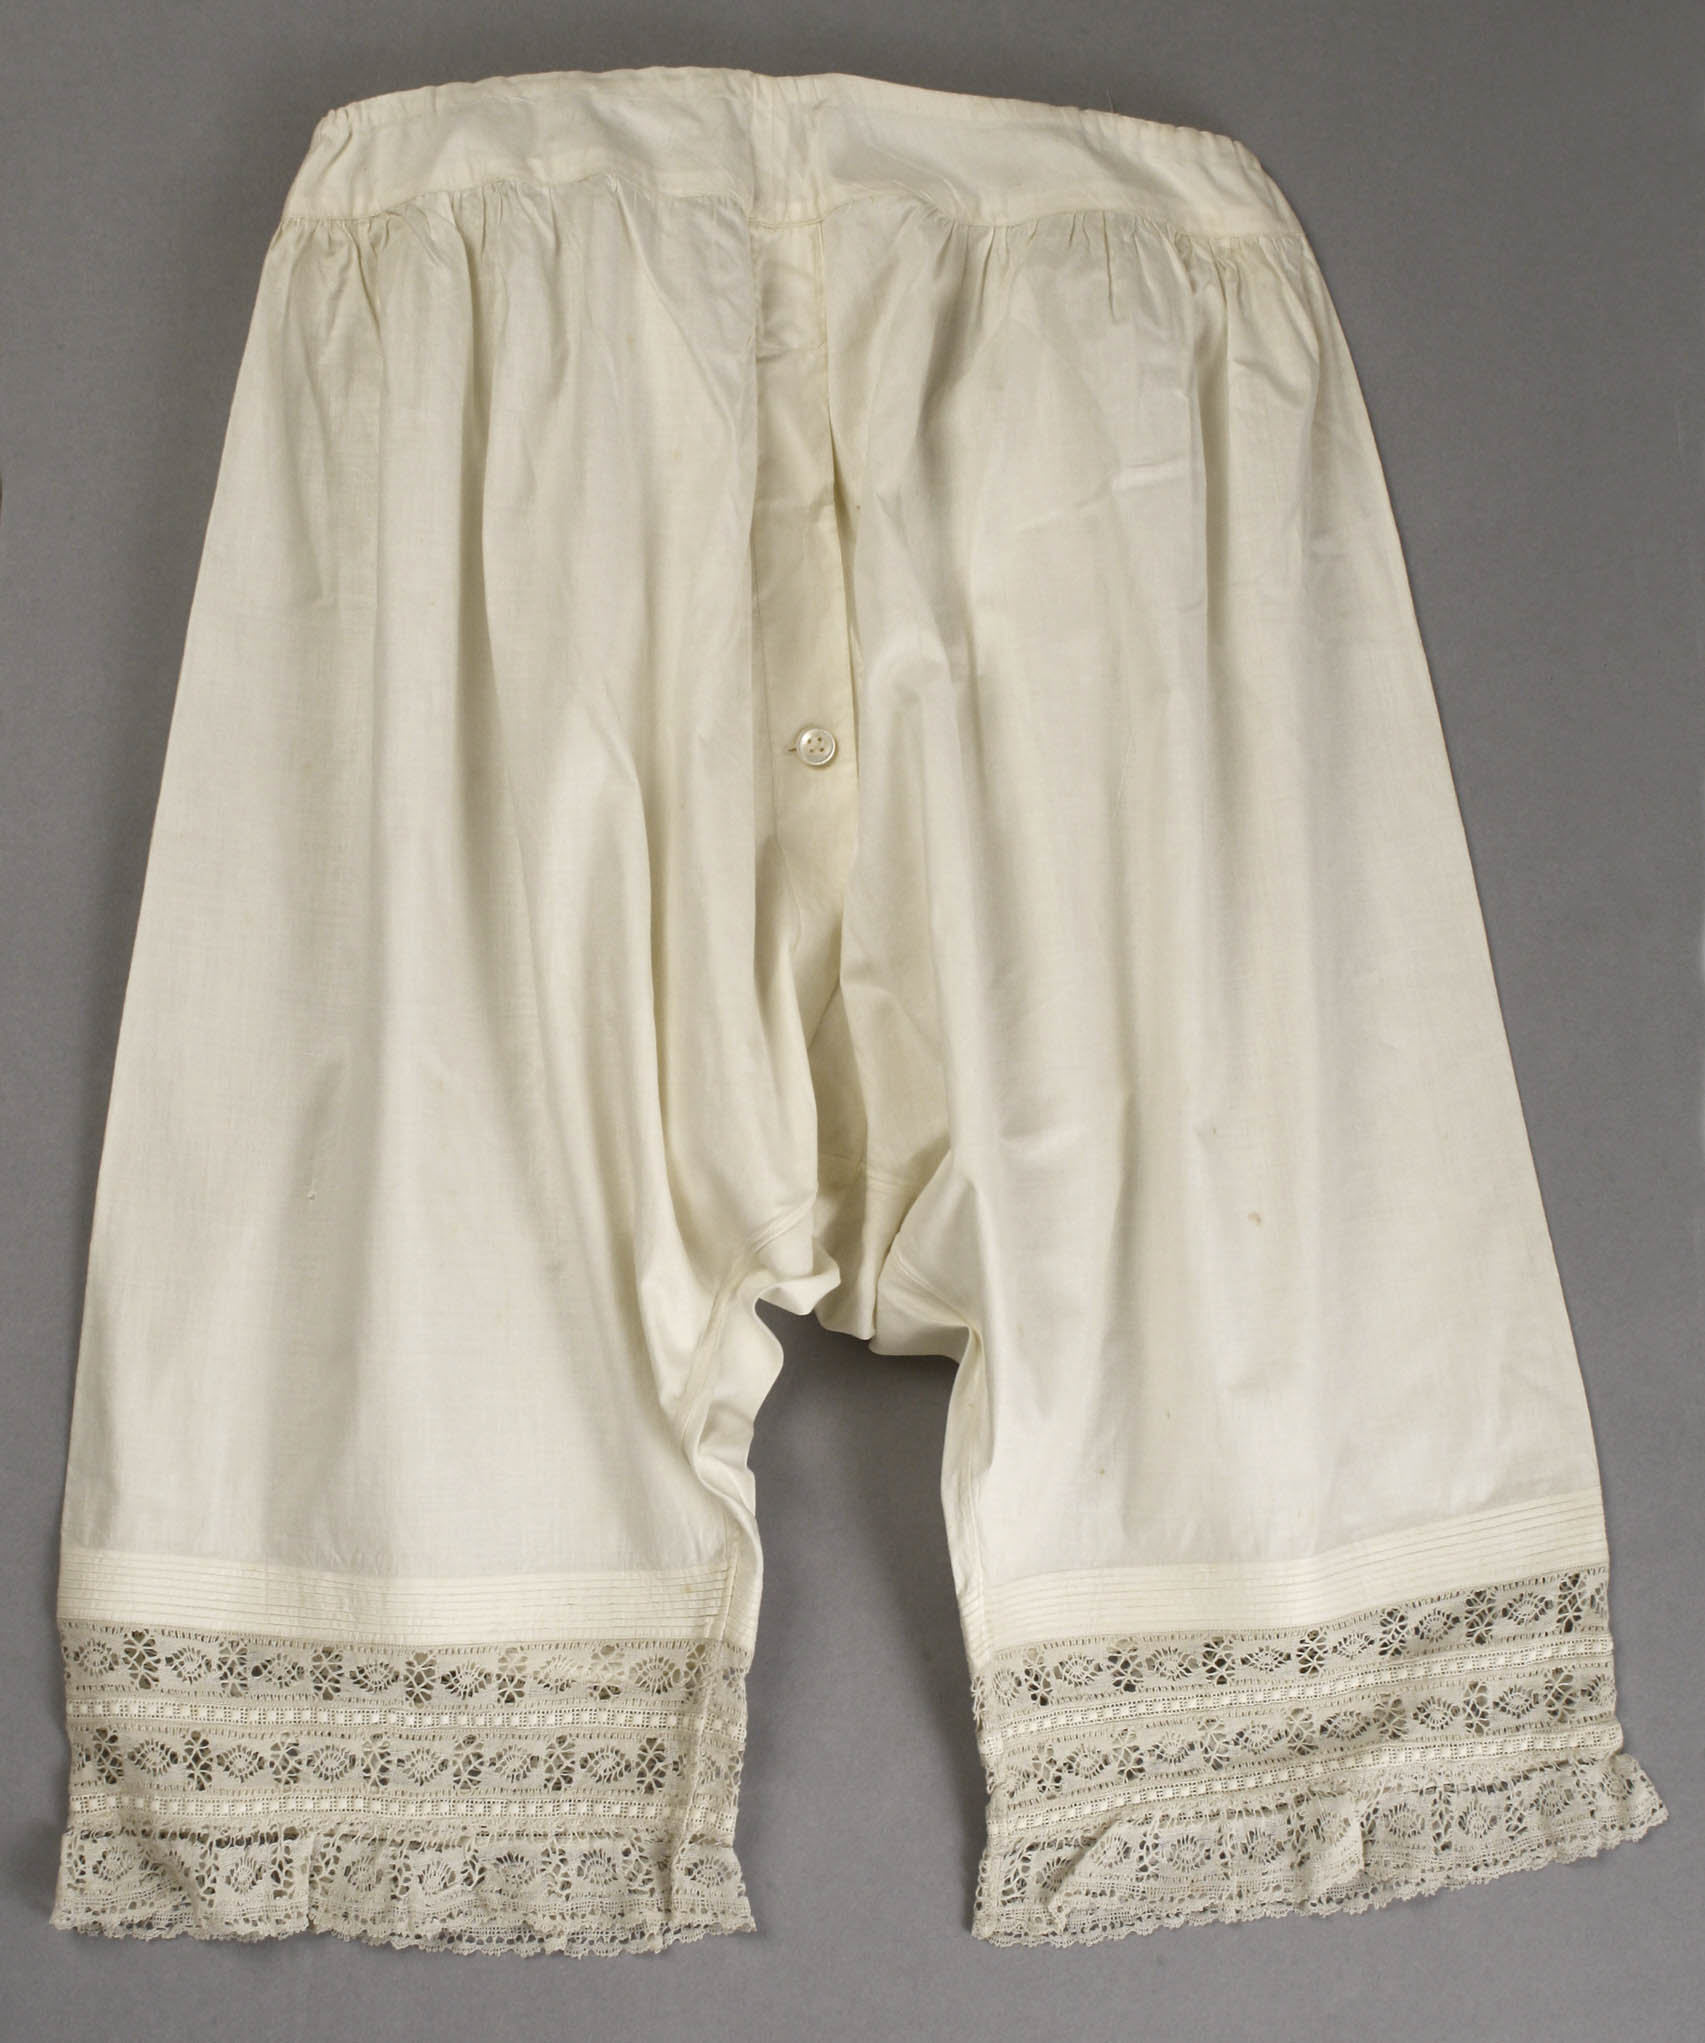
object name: drawer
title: Drawers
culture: american or european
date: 1888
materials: cotton